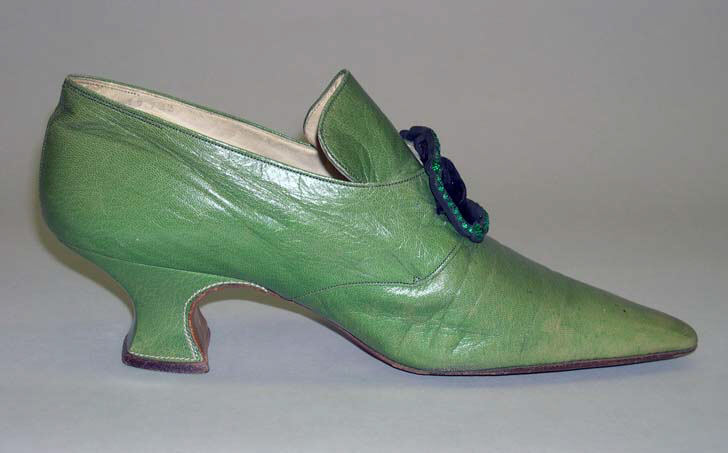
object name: slipper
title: Slippers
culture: french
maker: hellstern and sons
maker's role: manufacturer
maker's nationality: french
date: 1900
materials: leather